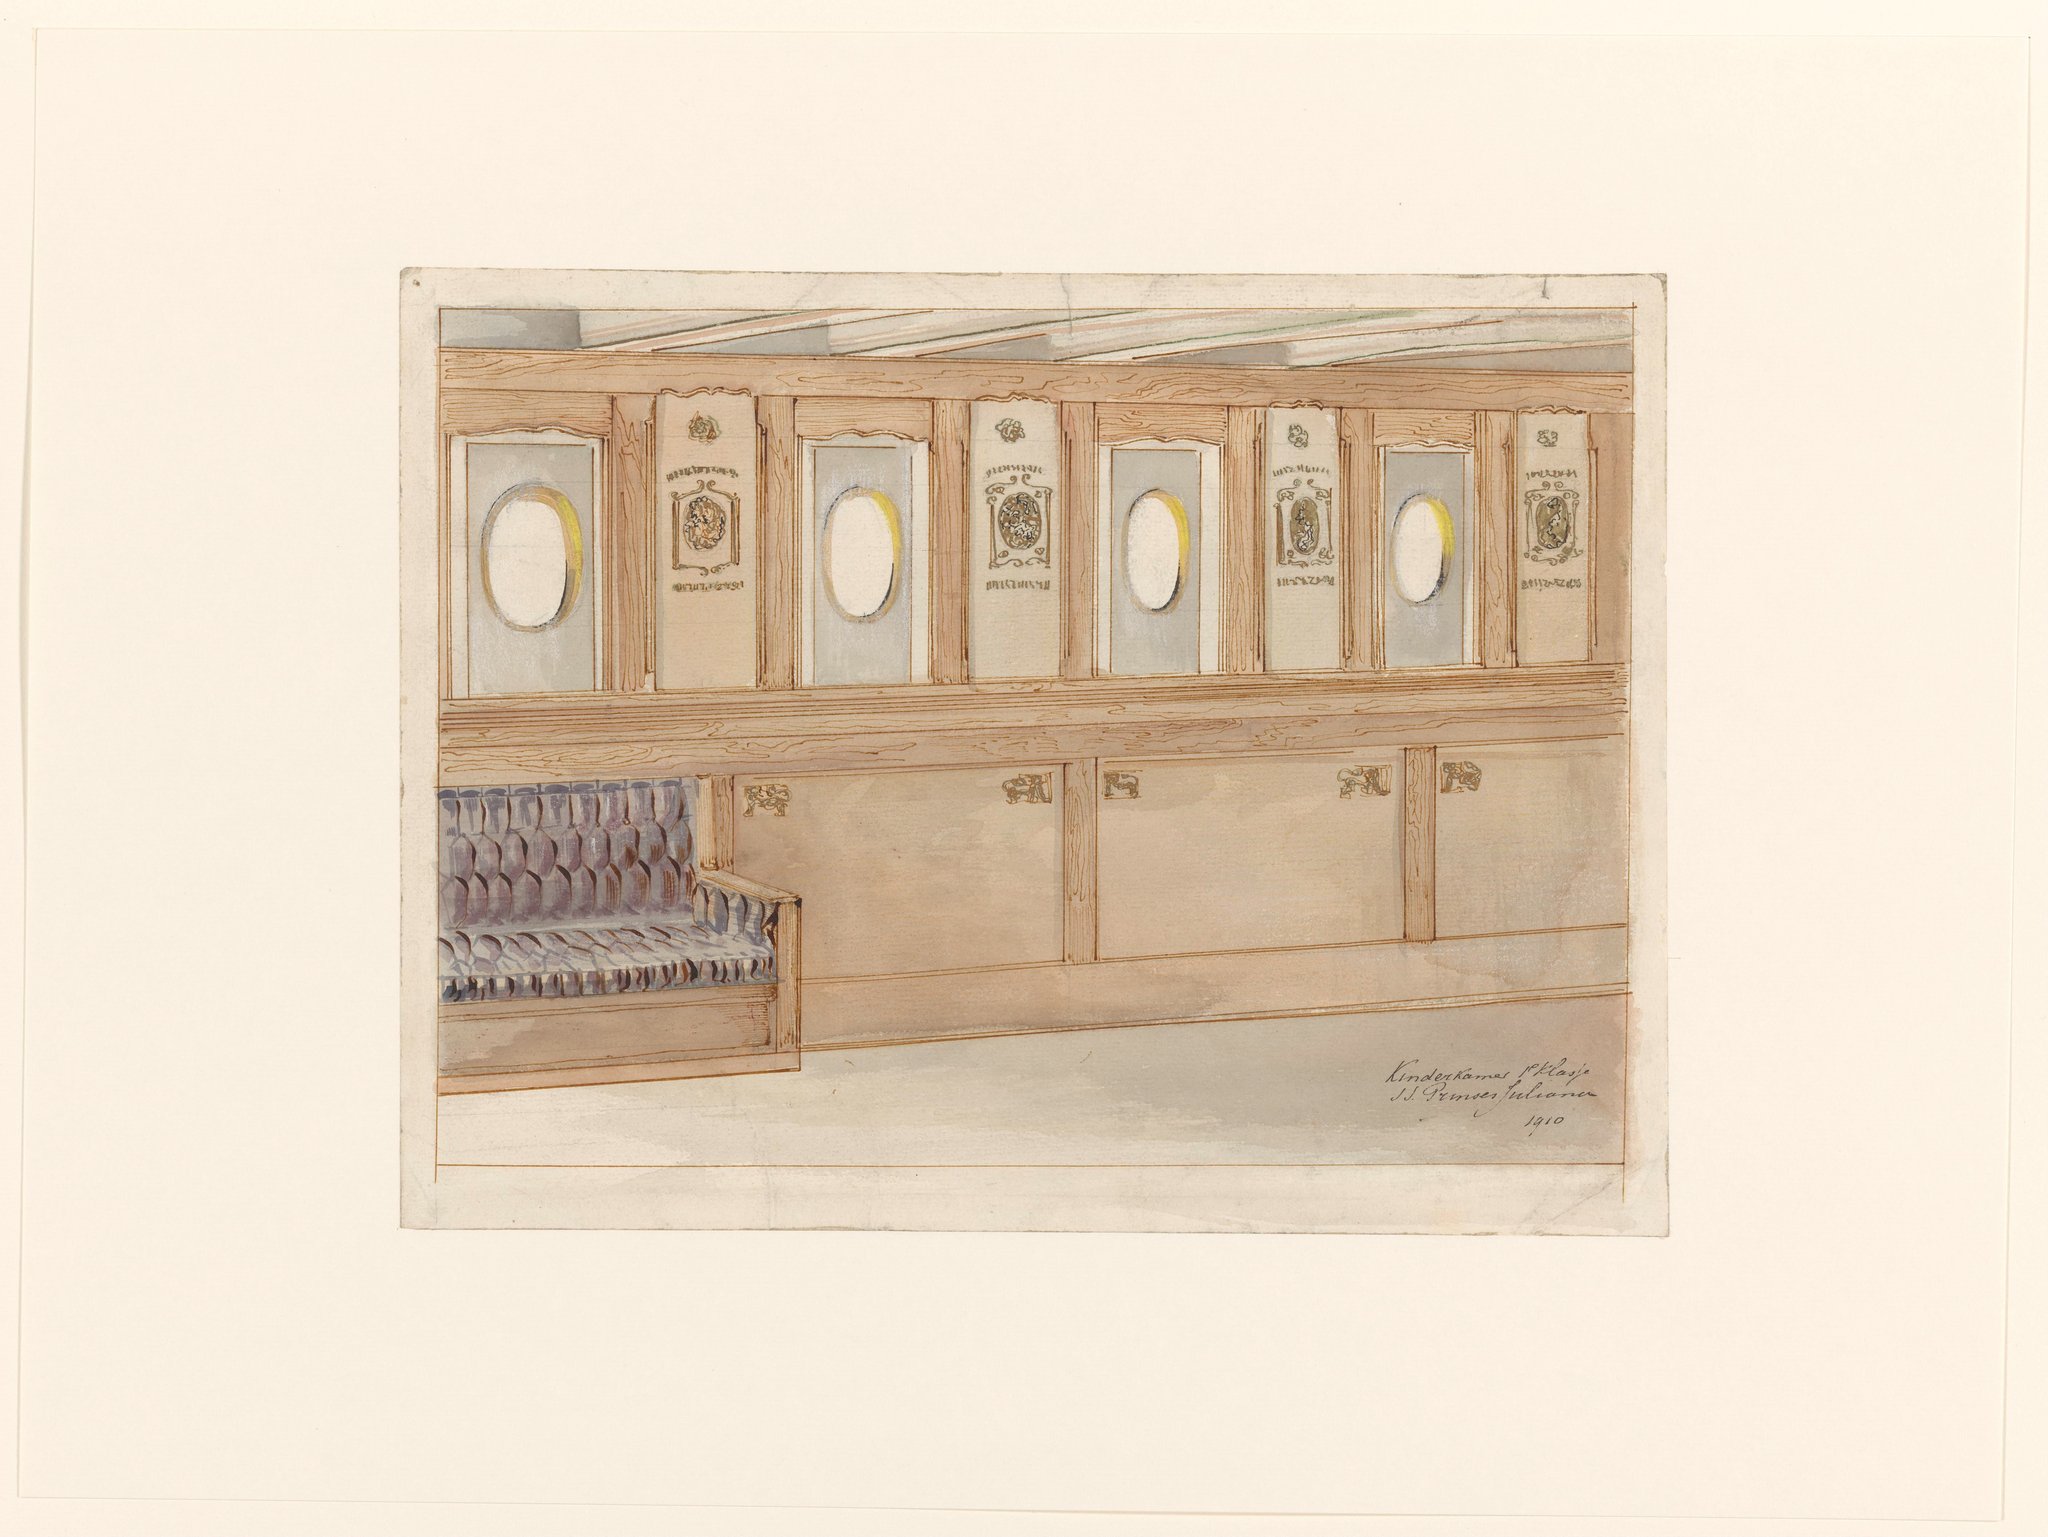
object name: watercolor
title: Ontwerp voor een kinderkamer Eerste Klas op de S.S. Prinses Juliana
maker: carel adolph lion cachet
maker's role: draughtsman, print maker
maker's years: 1864-1945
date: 1910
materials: ink, paper, pencil, watercolor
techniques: brush, pen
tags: names of artefacts and man-made objects (buildings excluded), interior of the house, parts of ship's interior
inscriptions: date: ‘1910’